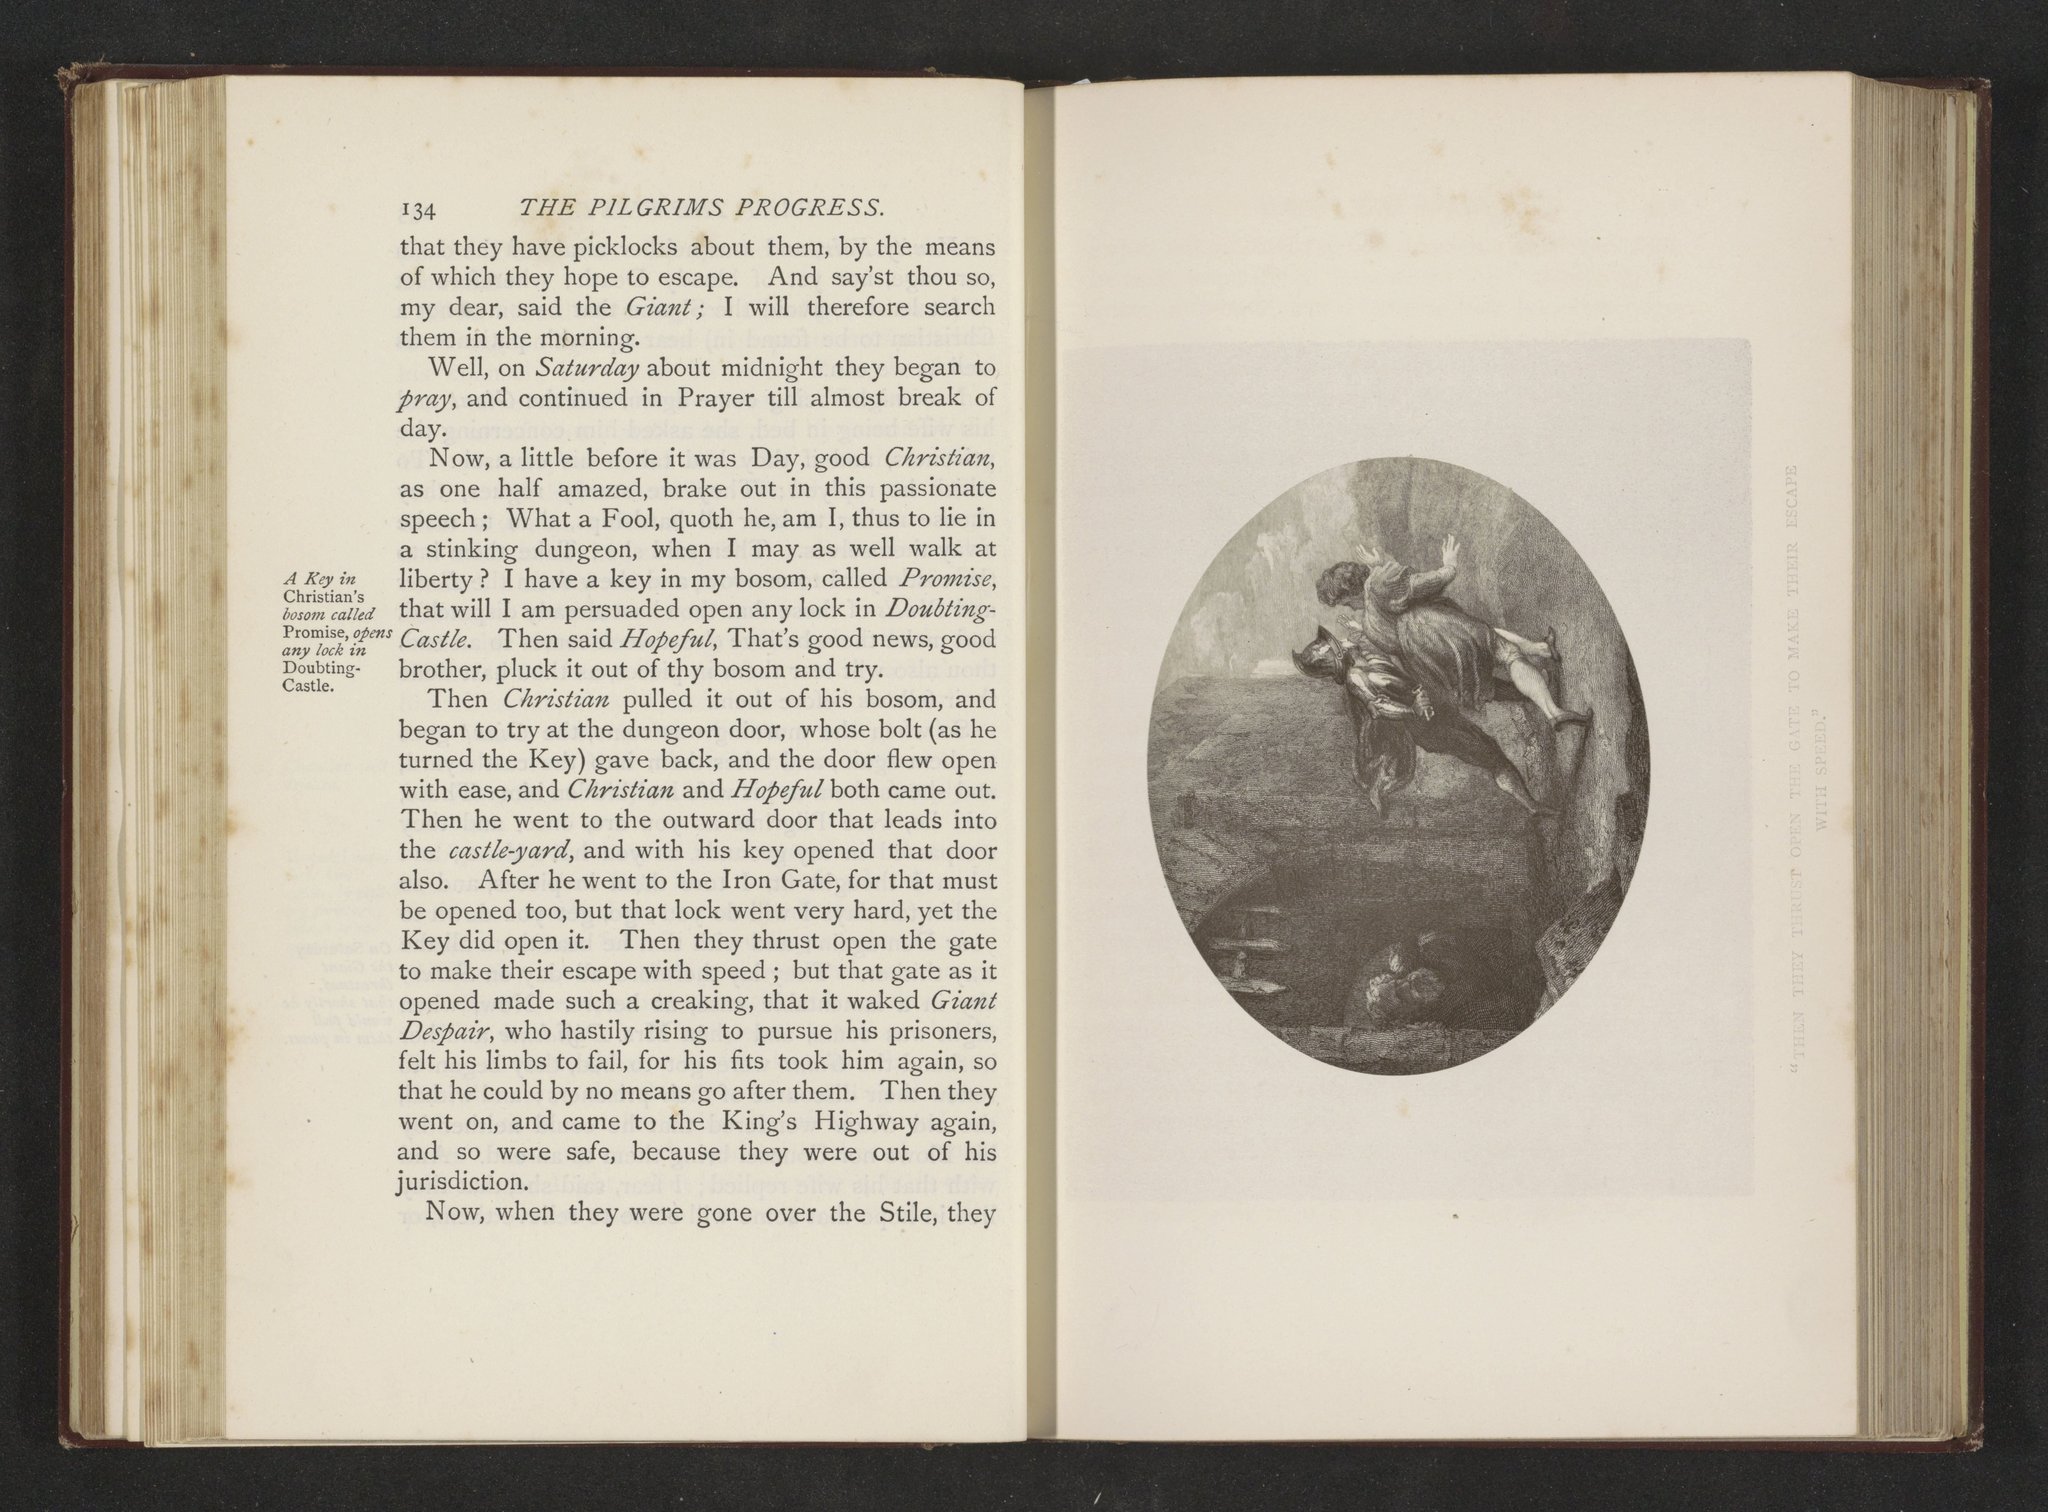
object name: photomechanical print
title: Fotoreproductie van een illustratie door Thomas Stothard voor Eens Christens reize naar de Eeuwigheid door John Bunyan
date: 1871-1881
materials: paper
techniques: woodburytype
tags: print, e.g.: engraving, etching, lithograph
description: Illustratie betreft Christen en Hoopvol die vluchten.